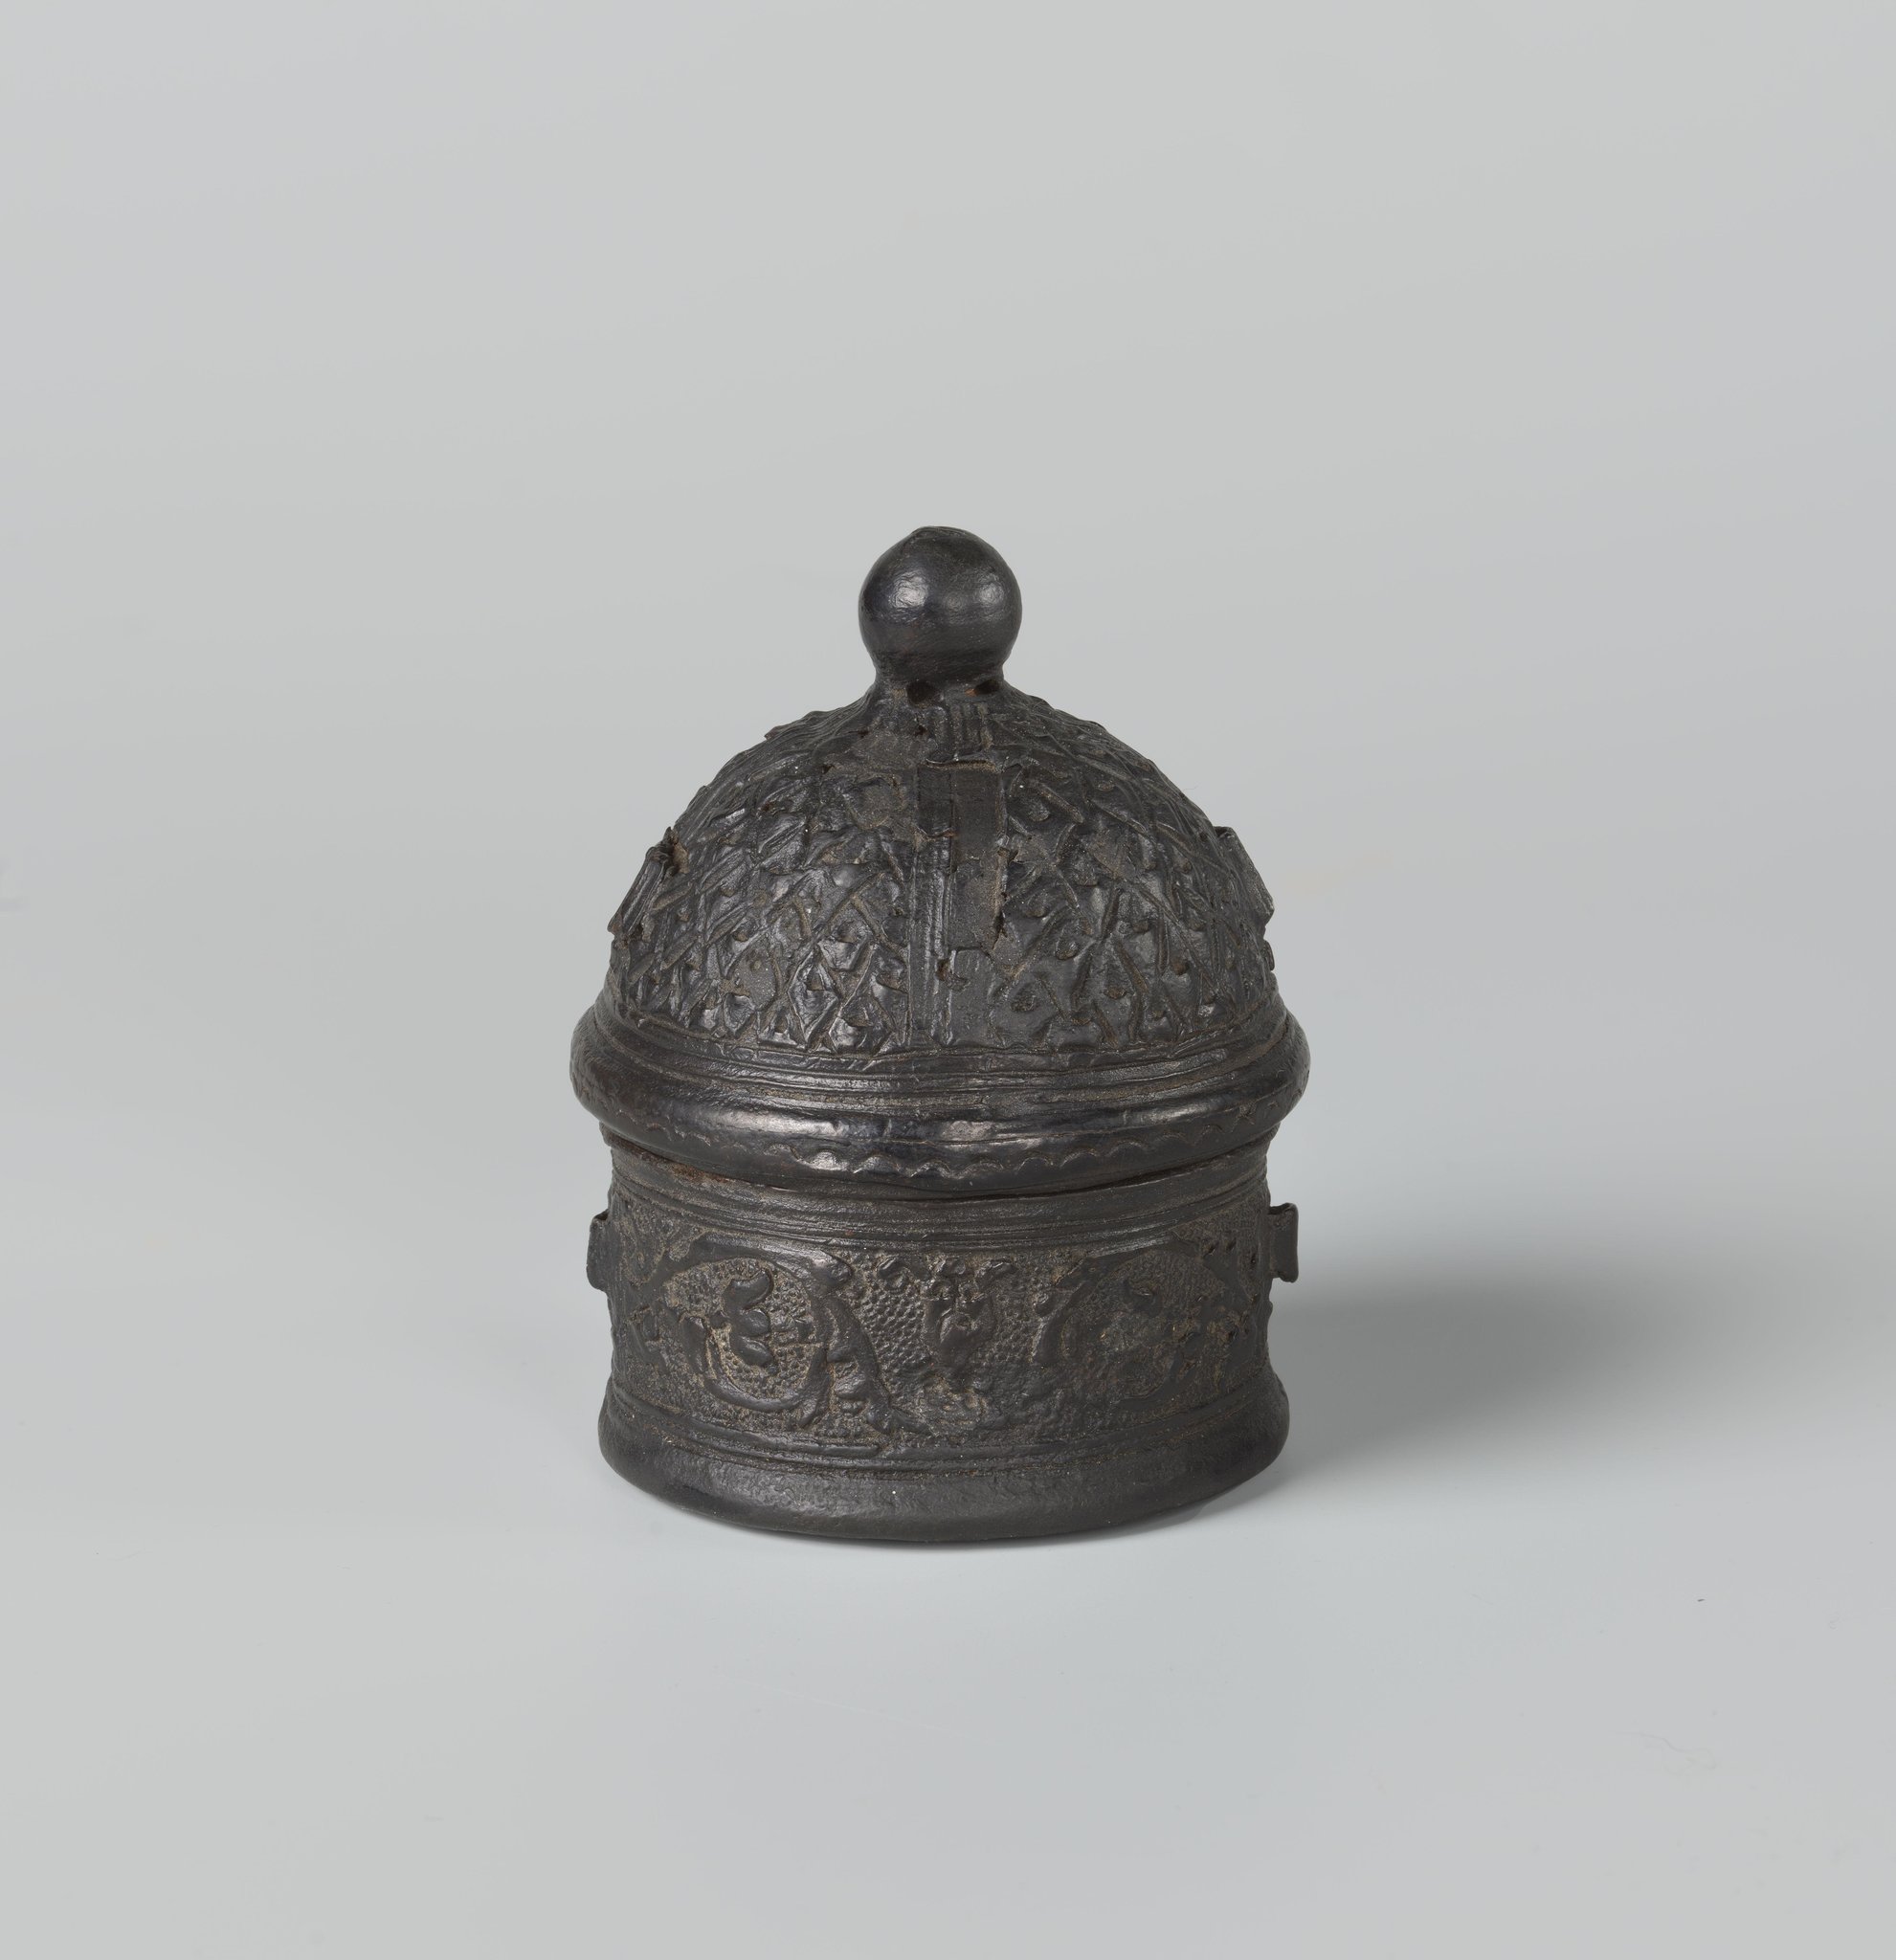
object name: case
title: Inktpotfoedraal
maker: Anonymous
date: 1400-1499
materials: leather, velvet, wood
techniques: upholstery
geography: florence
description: Een cilindervormig doosje met los koepelvormig deksel, bekroond door een knopje. De gedraaid houten kern is bekleed met zogenaamd cuir bouilli, zwart gekookt leer, waarin motieven zijn geperst: op de cilinder rondom een band met een golvende acanthustak tegen gestippelde achtergrond en aan de onder- en bovenzijde begrensd door een profielrand, deels versierd met kleine golflijntjes. Het koepelvormig deksel is verdeeld in vier gelijke secties, elk voorzien van een ruitpatroon. Doosje en dekseltje hebben kleine 'lusjes' waardoor een koordje kan worden getrokken op het geheel bijeen te houden en op te hangen. Dit kleine foedraal bevatte oorspronkelijk een glazen inktpotje. De binnenzijde is bekleed met rood fluweel (sleets).